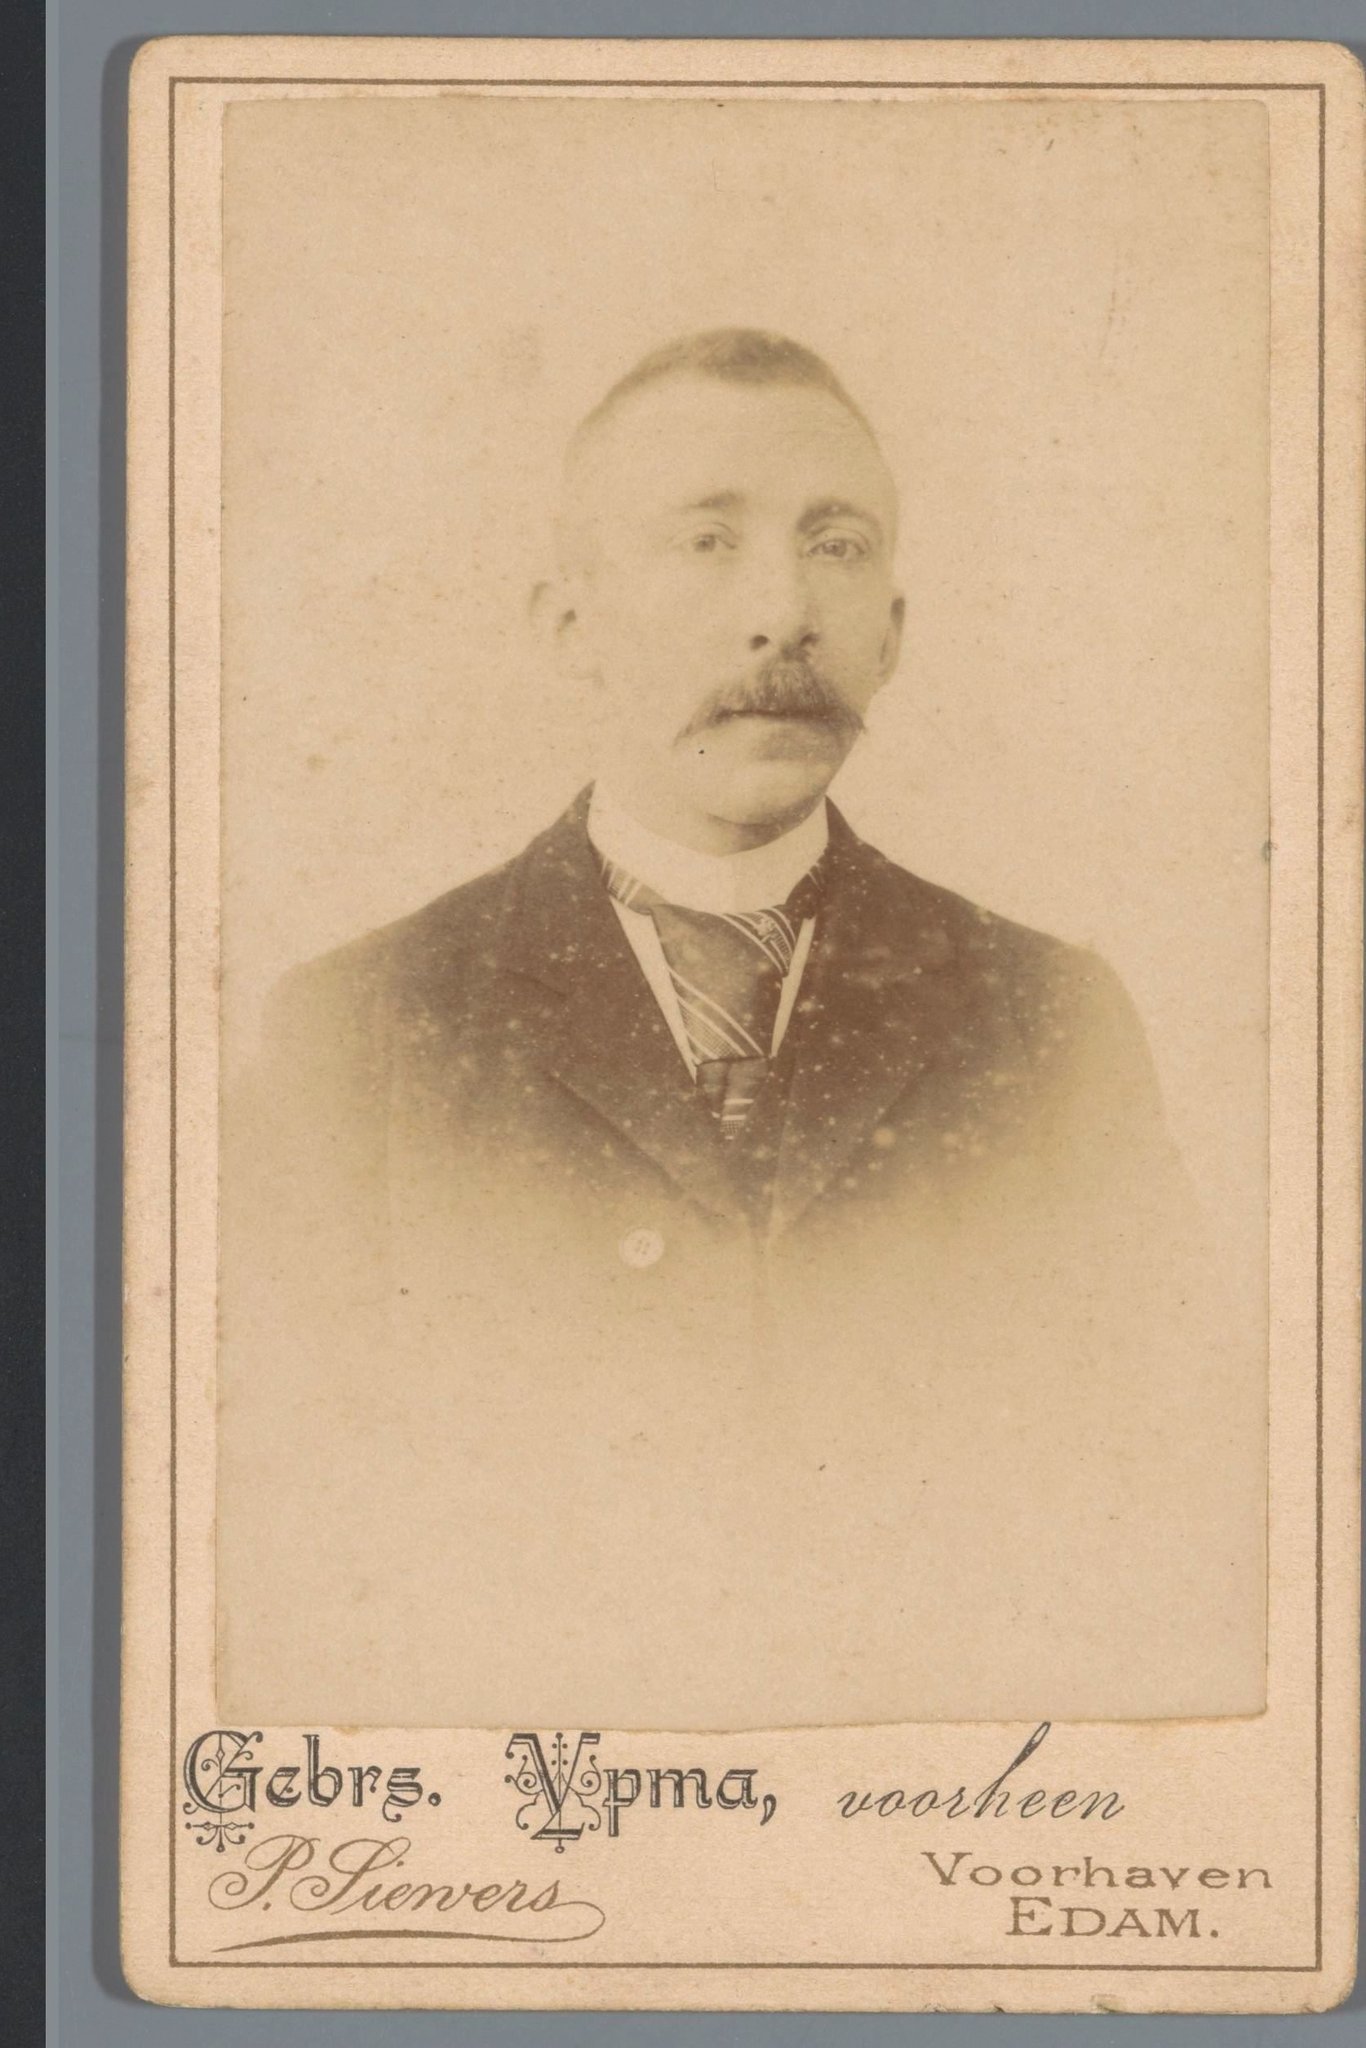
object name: photograph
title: Portret van een onbekende man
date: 1894-1898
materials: cardboard, paper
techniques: albumen print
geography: edam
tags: adult man, historical persons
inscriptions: inscription: ‘Photographie/ Instantanée/ Gebrs. IJpma, voorheen/ P. Siewers/ Voorhaven/ b/d R. C. Kerk/ EDAM/ Het Cliché blijft ter nabestelling bewaard’